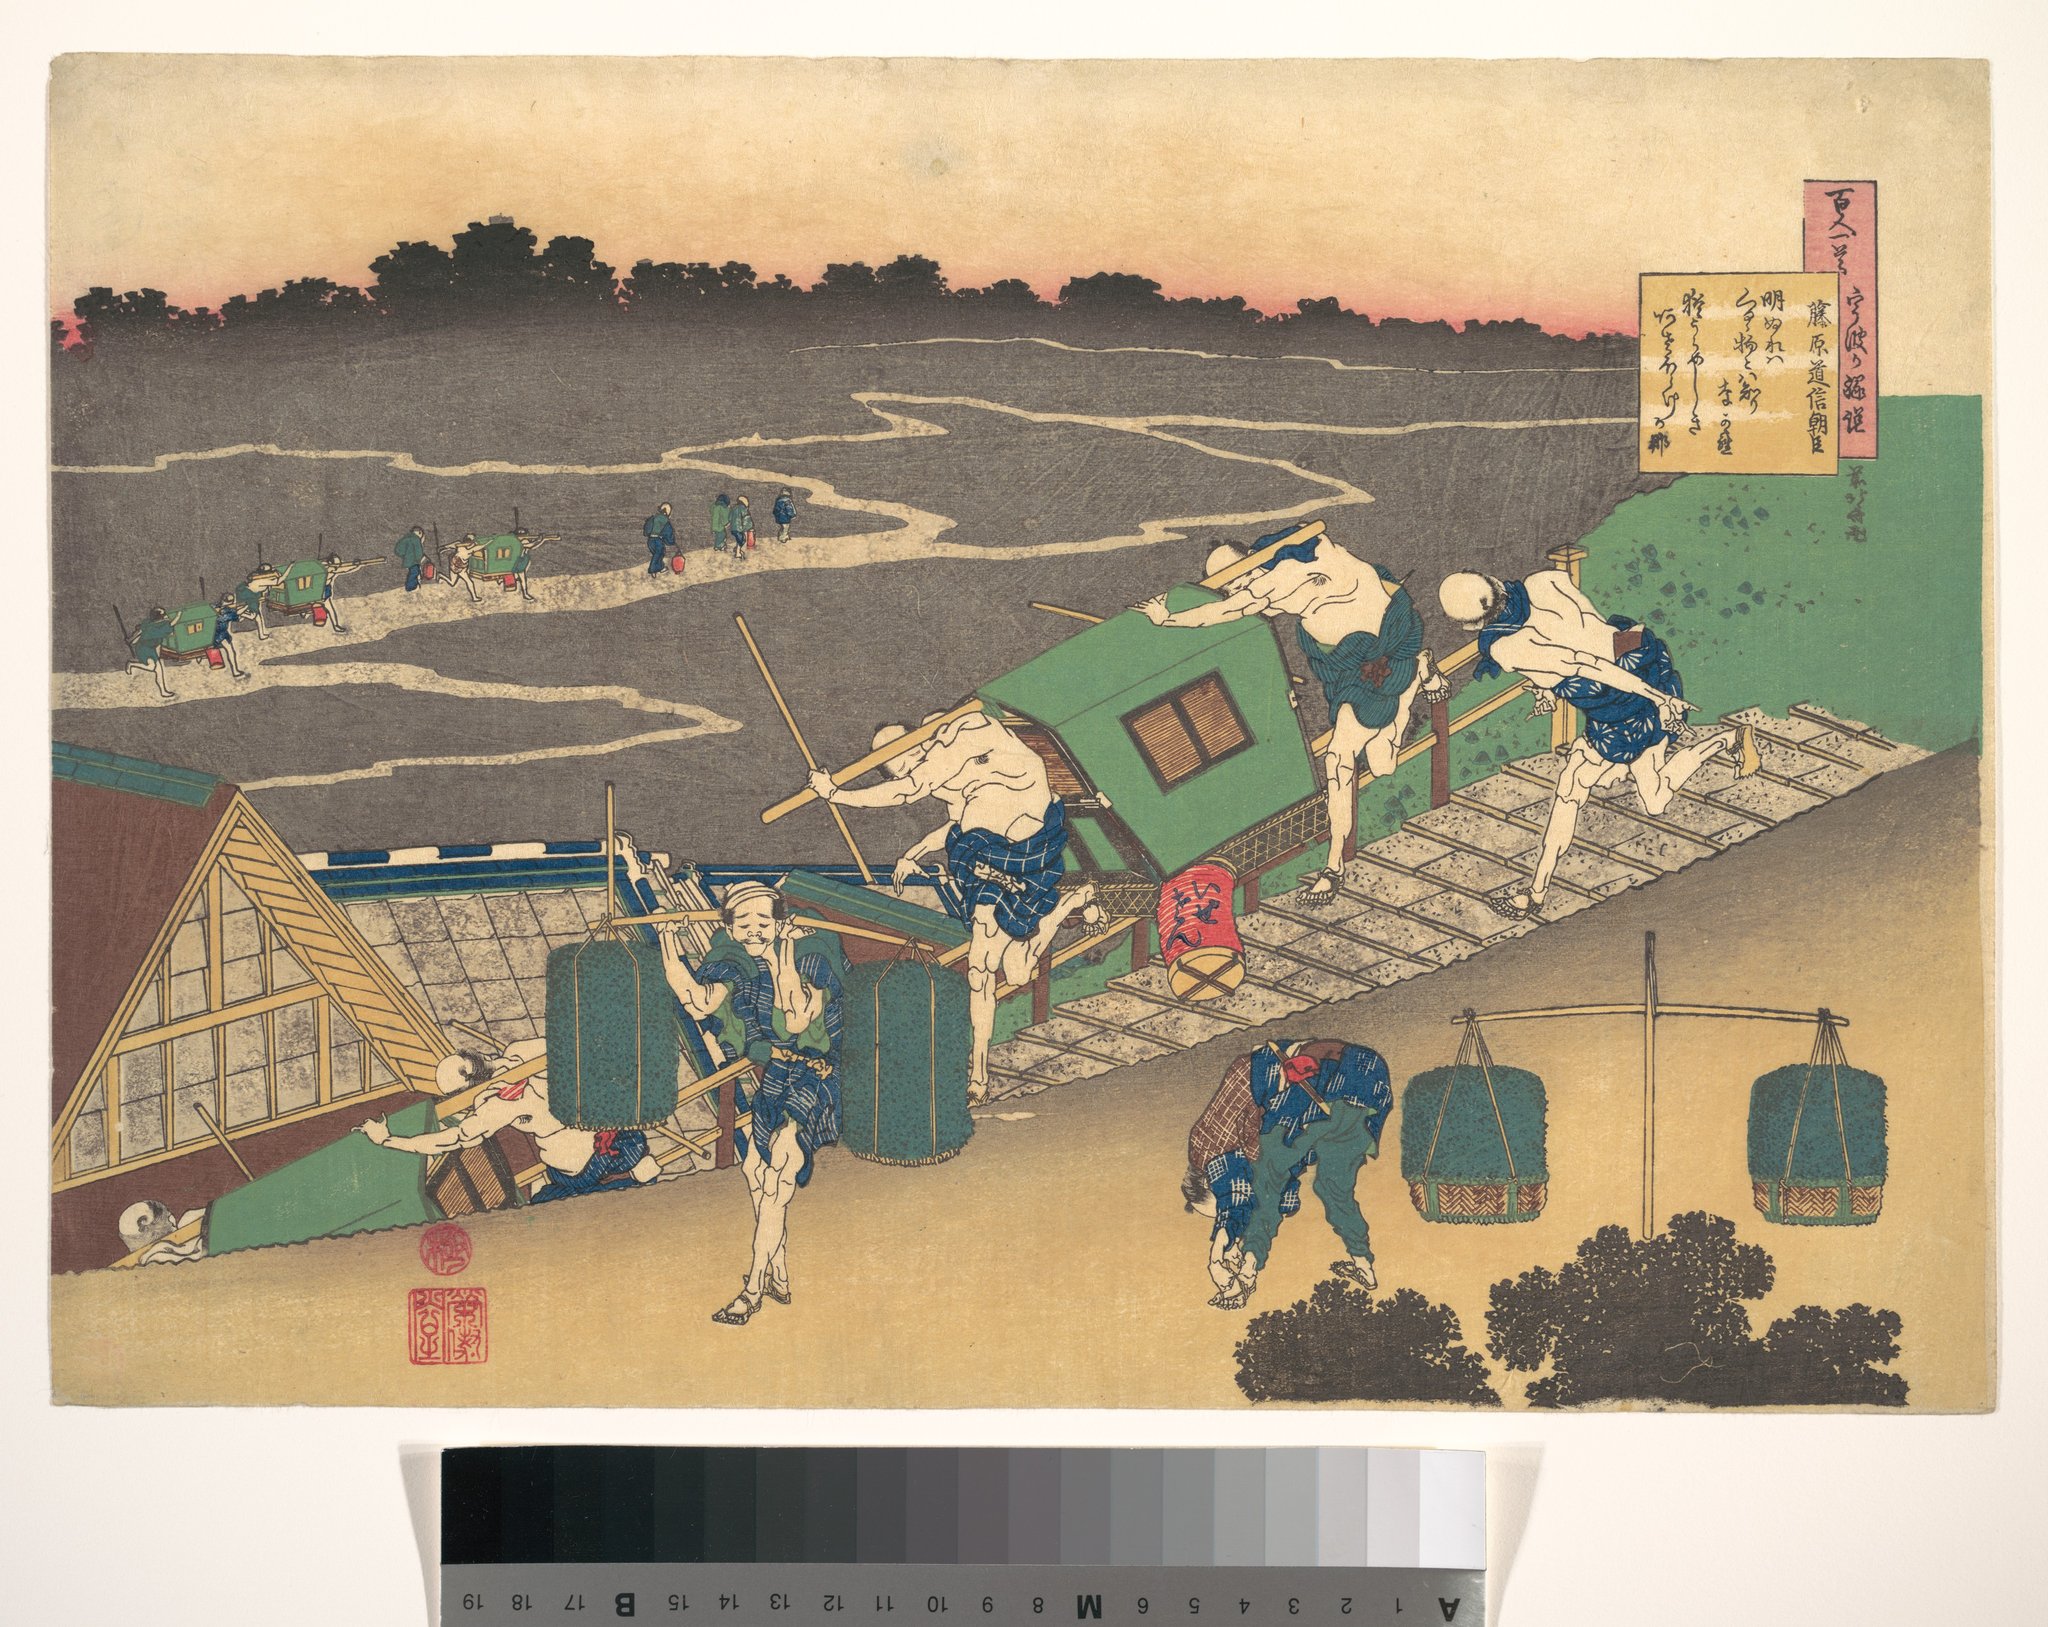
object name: woodblock print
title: Poem by Fujiwara no Michinobu Ason, from the series One Hundred Poems Explained by the Nurse (Hyakunin isshu uba ga etoki)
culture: japanese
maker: katsushika hokusai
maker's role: artist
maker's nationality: japanese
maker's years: 1760-1849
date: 1760-1845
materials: ink, paper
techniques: woodblock print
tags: poetry,men